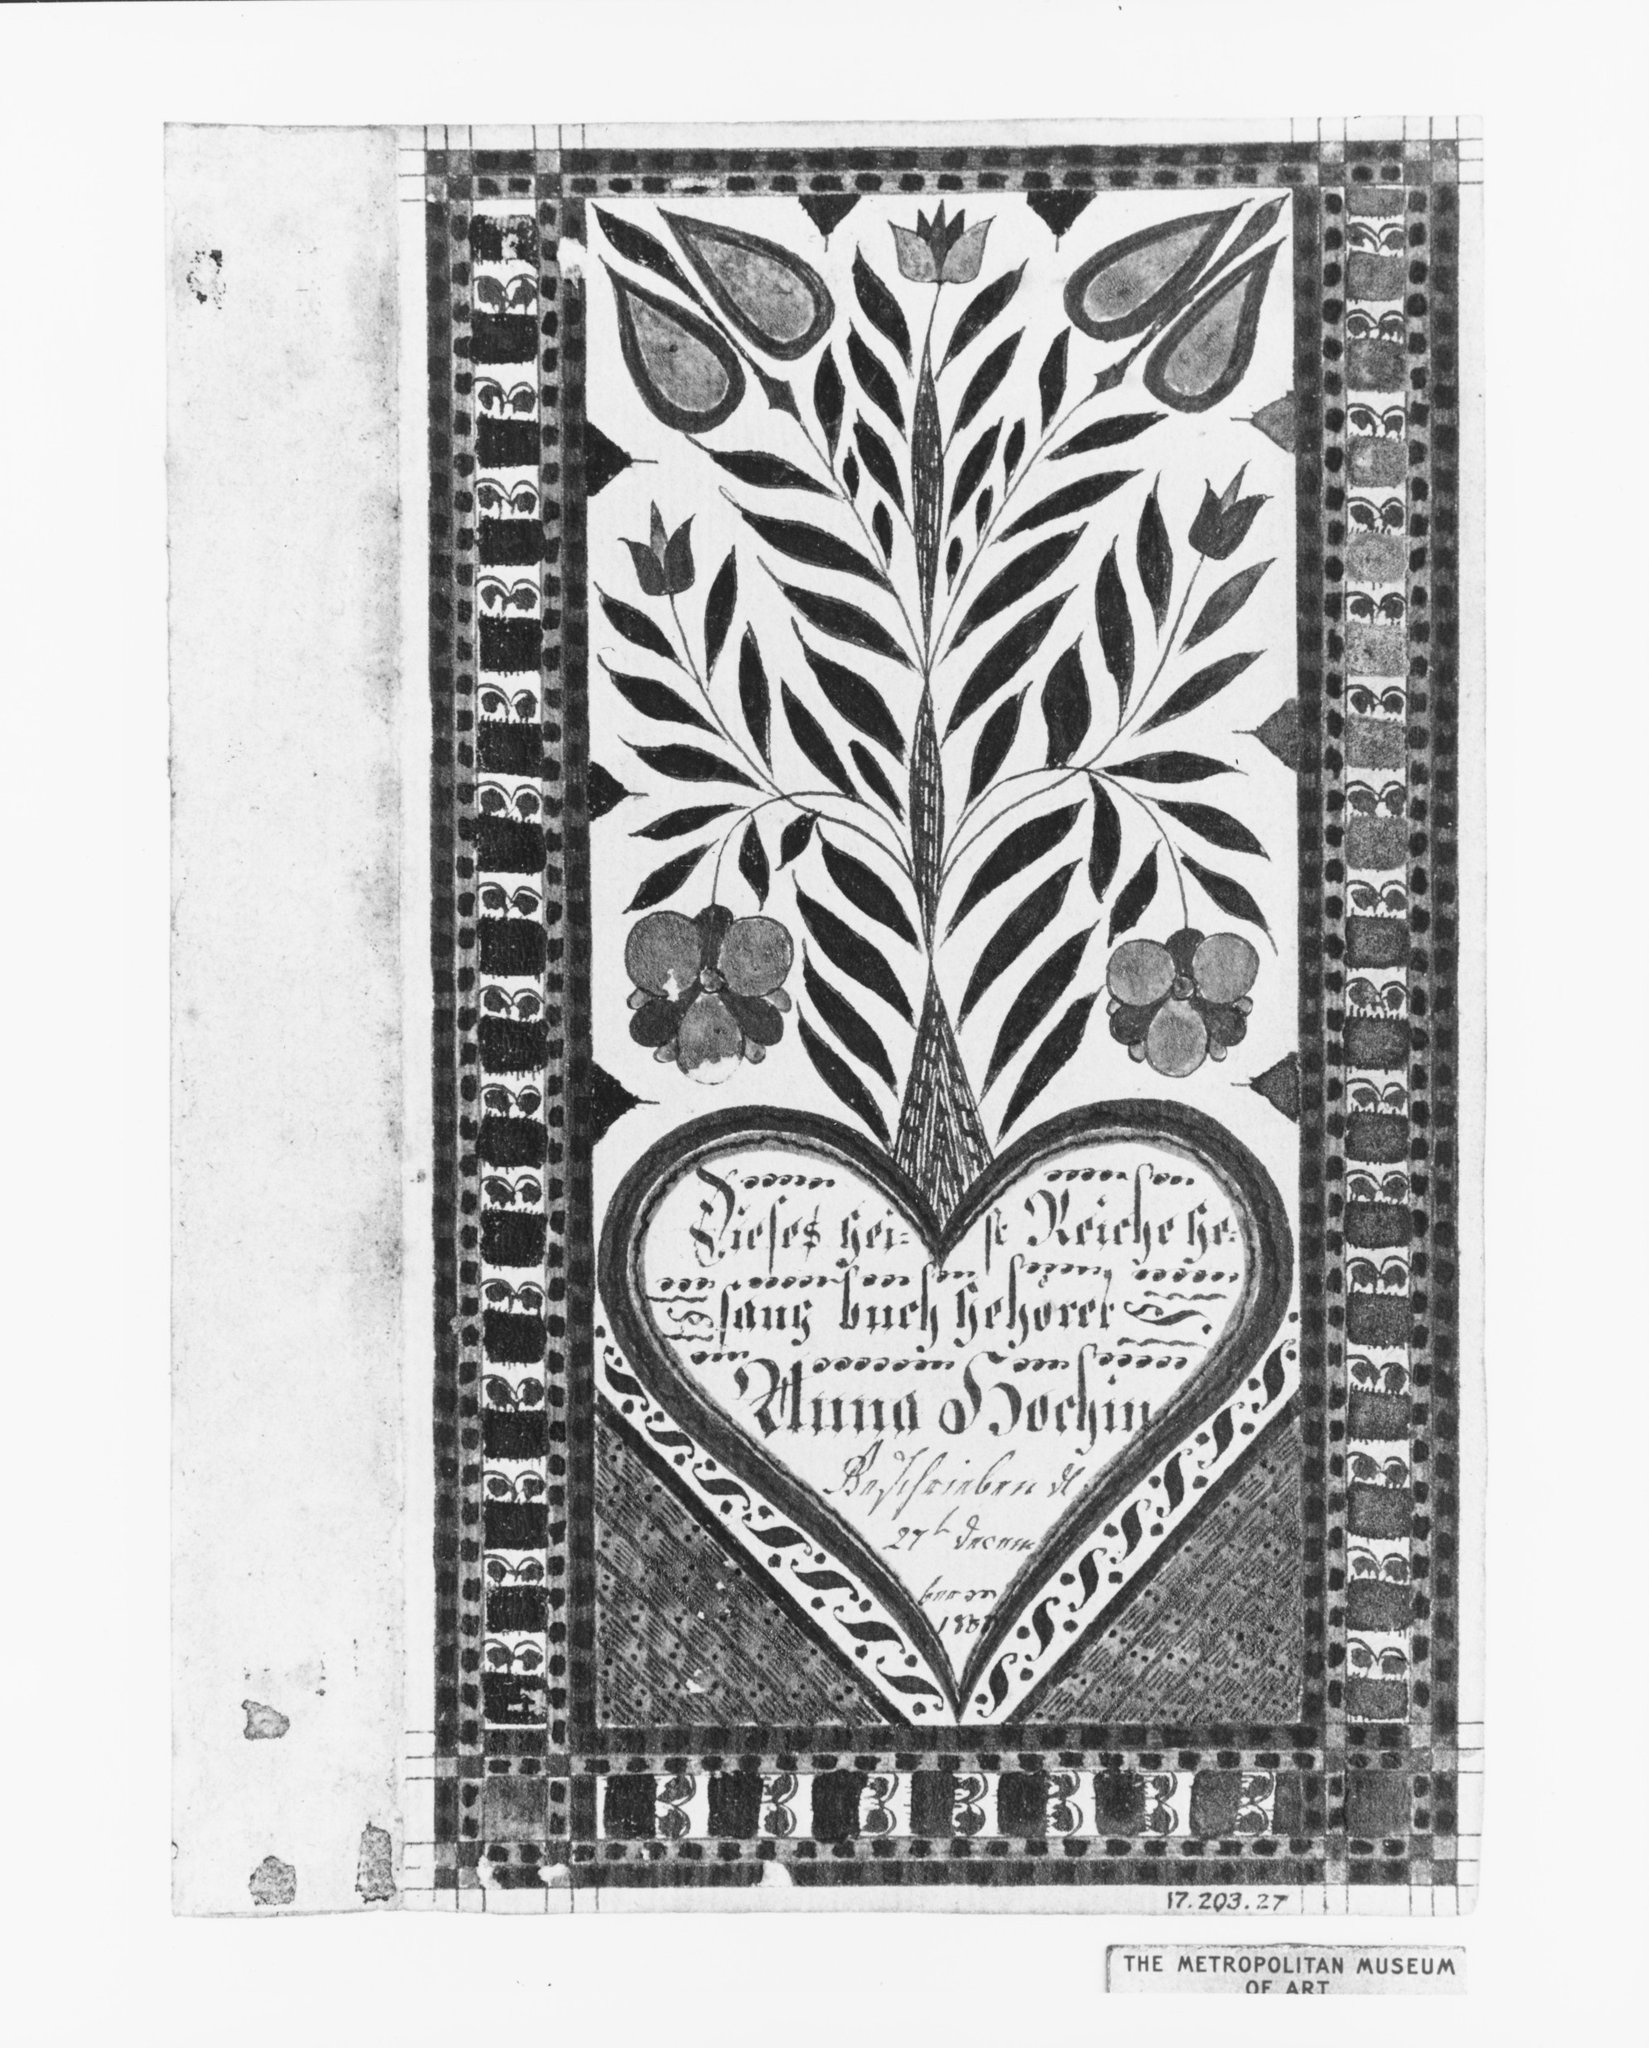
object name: flyleaf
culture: american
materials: paper